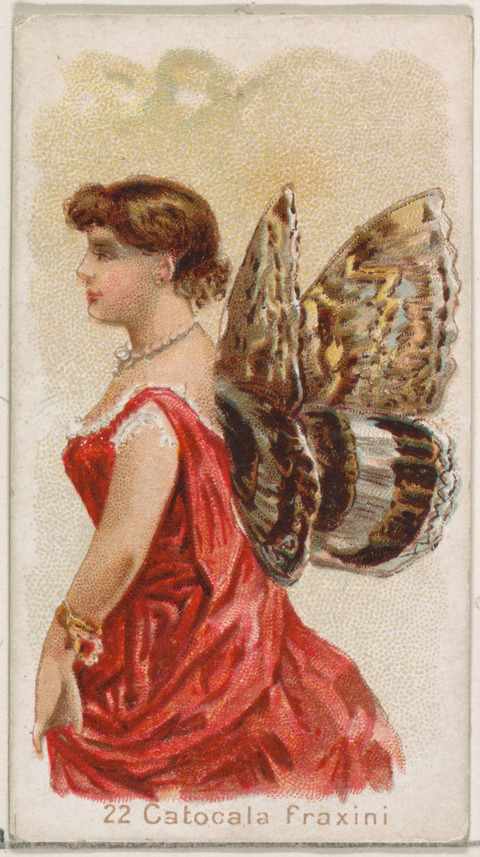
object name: print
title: Card 22, Catogala Fraxini, from the Butterflies series (N183) issued by Wm. S. Kimball & Co.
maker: william s. kimball & company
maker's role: publisher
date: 1888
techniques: color lithograph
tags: profiles,women,butterflies